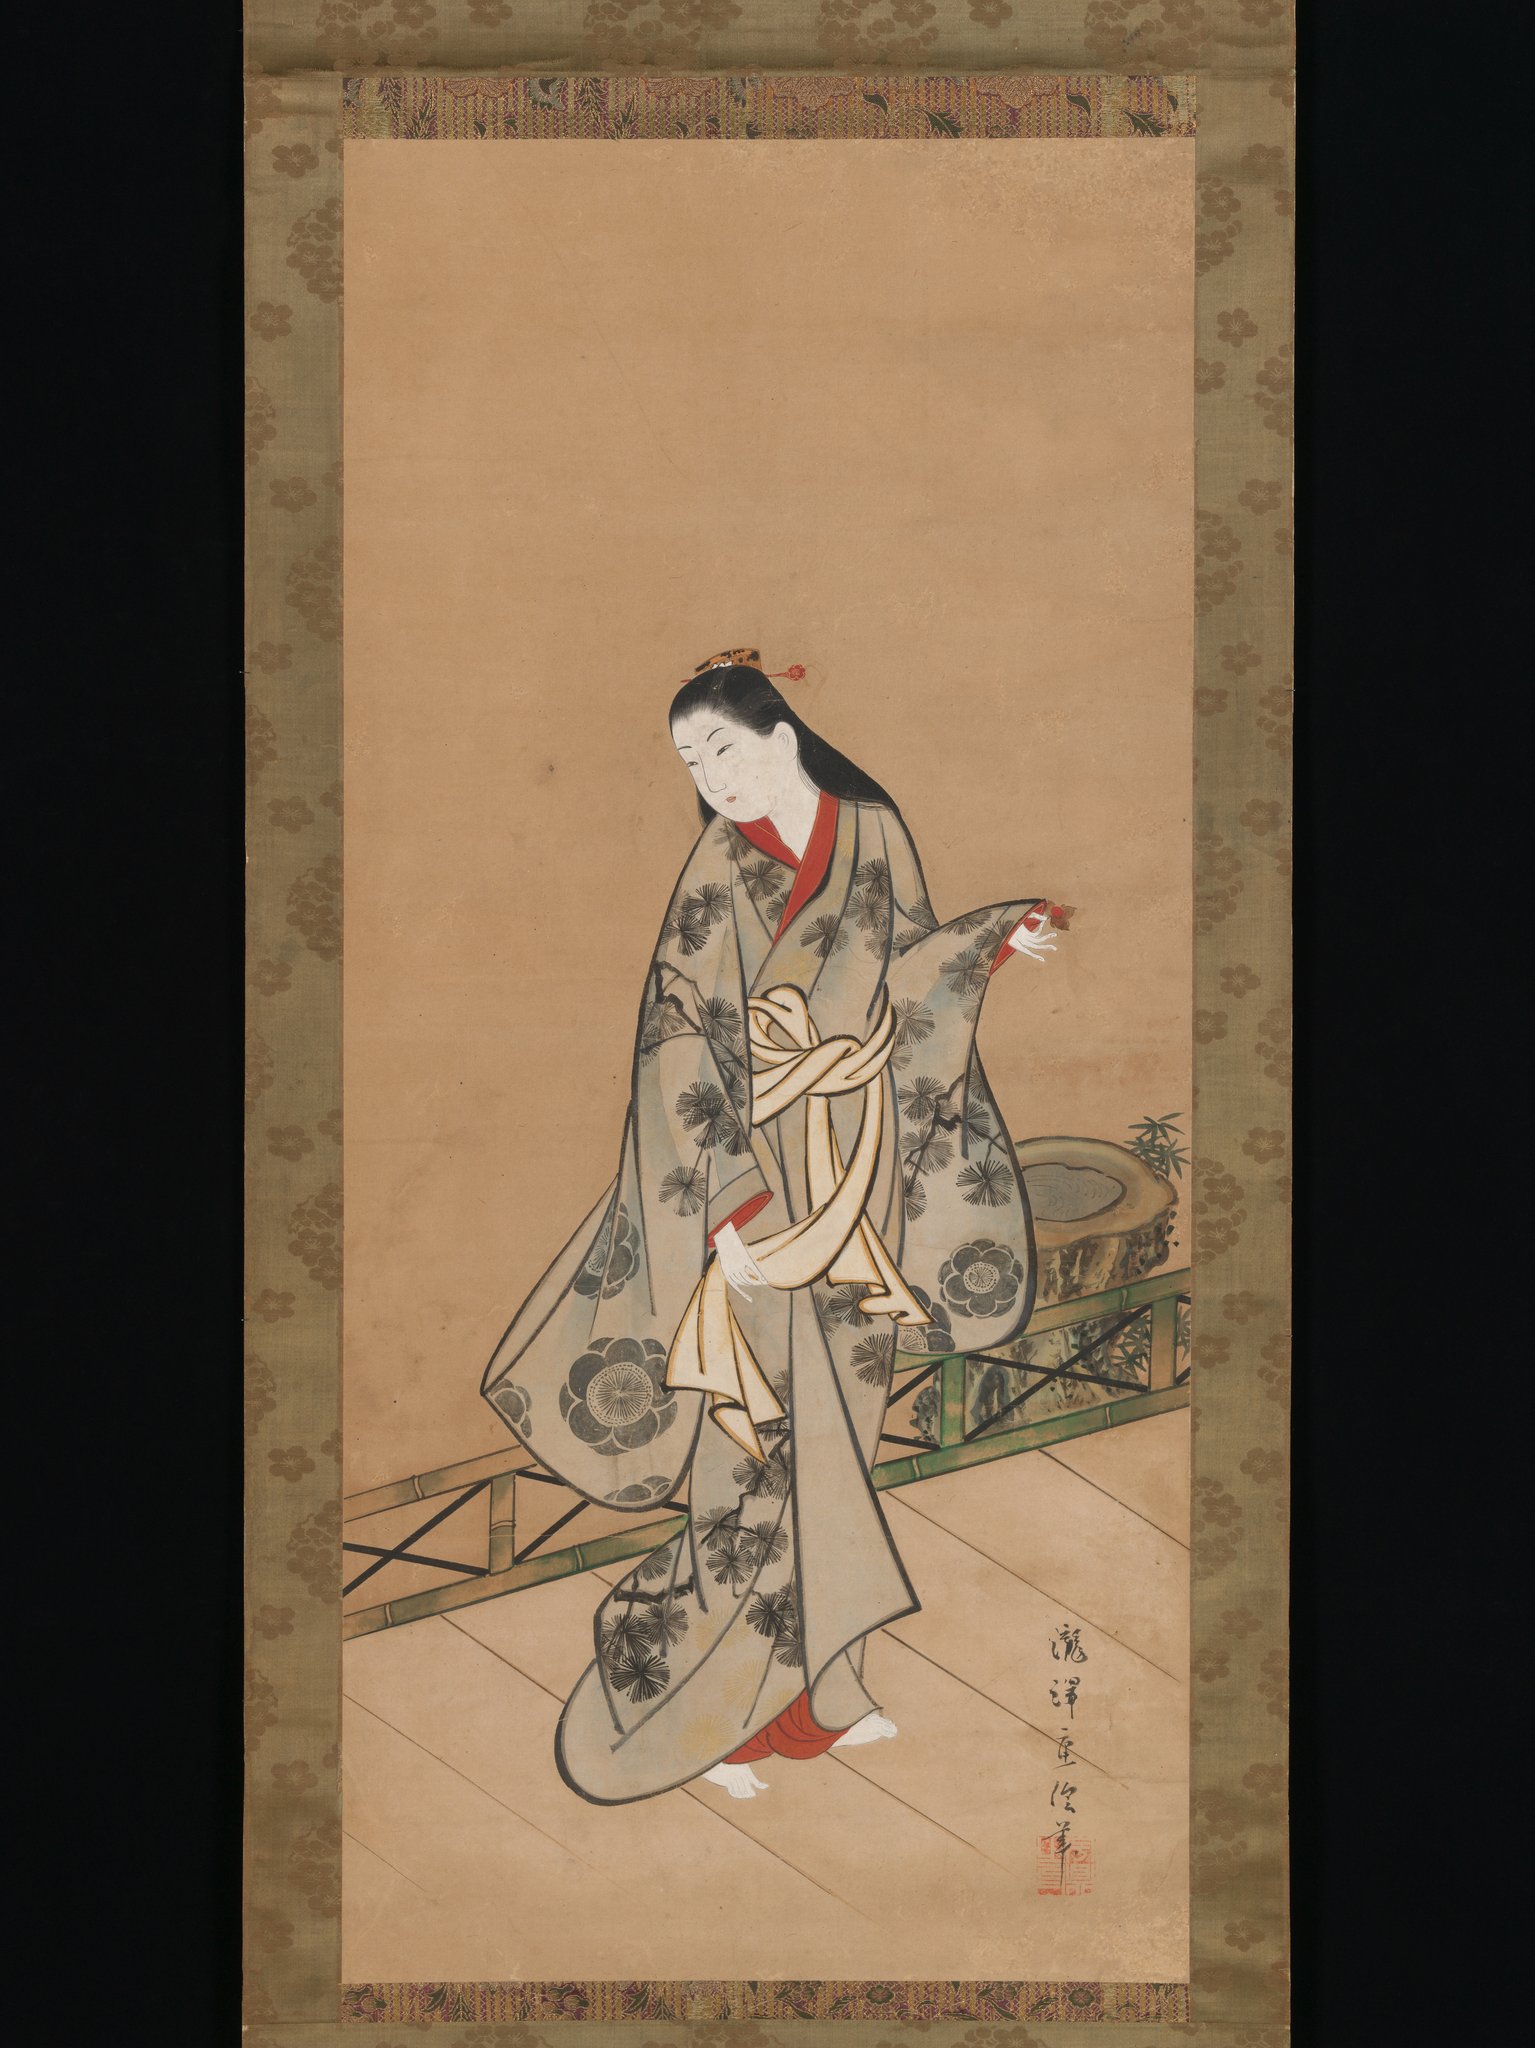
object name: hanging scroll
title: Woman on Veranda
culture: japanese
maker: takizawa shigenobu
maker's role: artist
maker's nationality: japanese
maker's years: 1700-1799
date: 1730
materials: ink, silk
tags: women